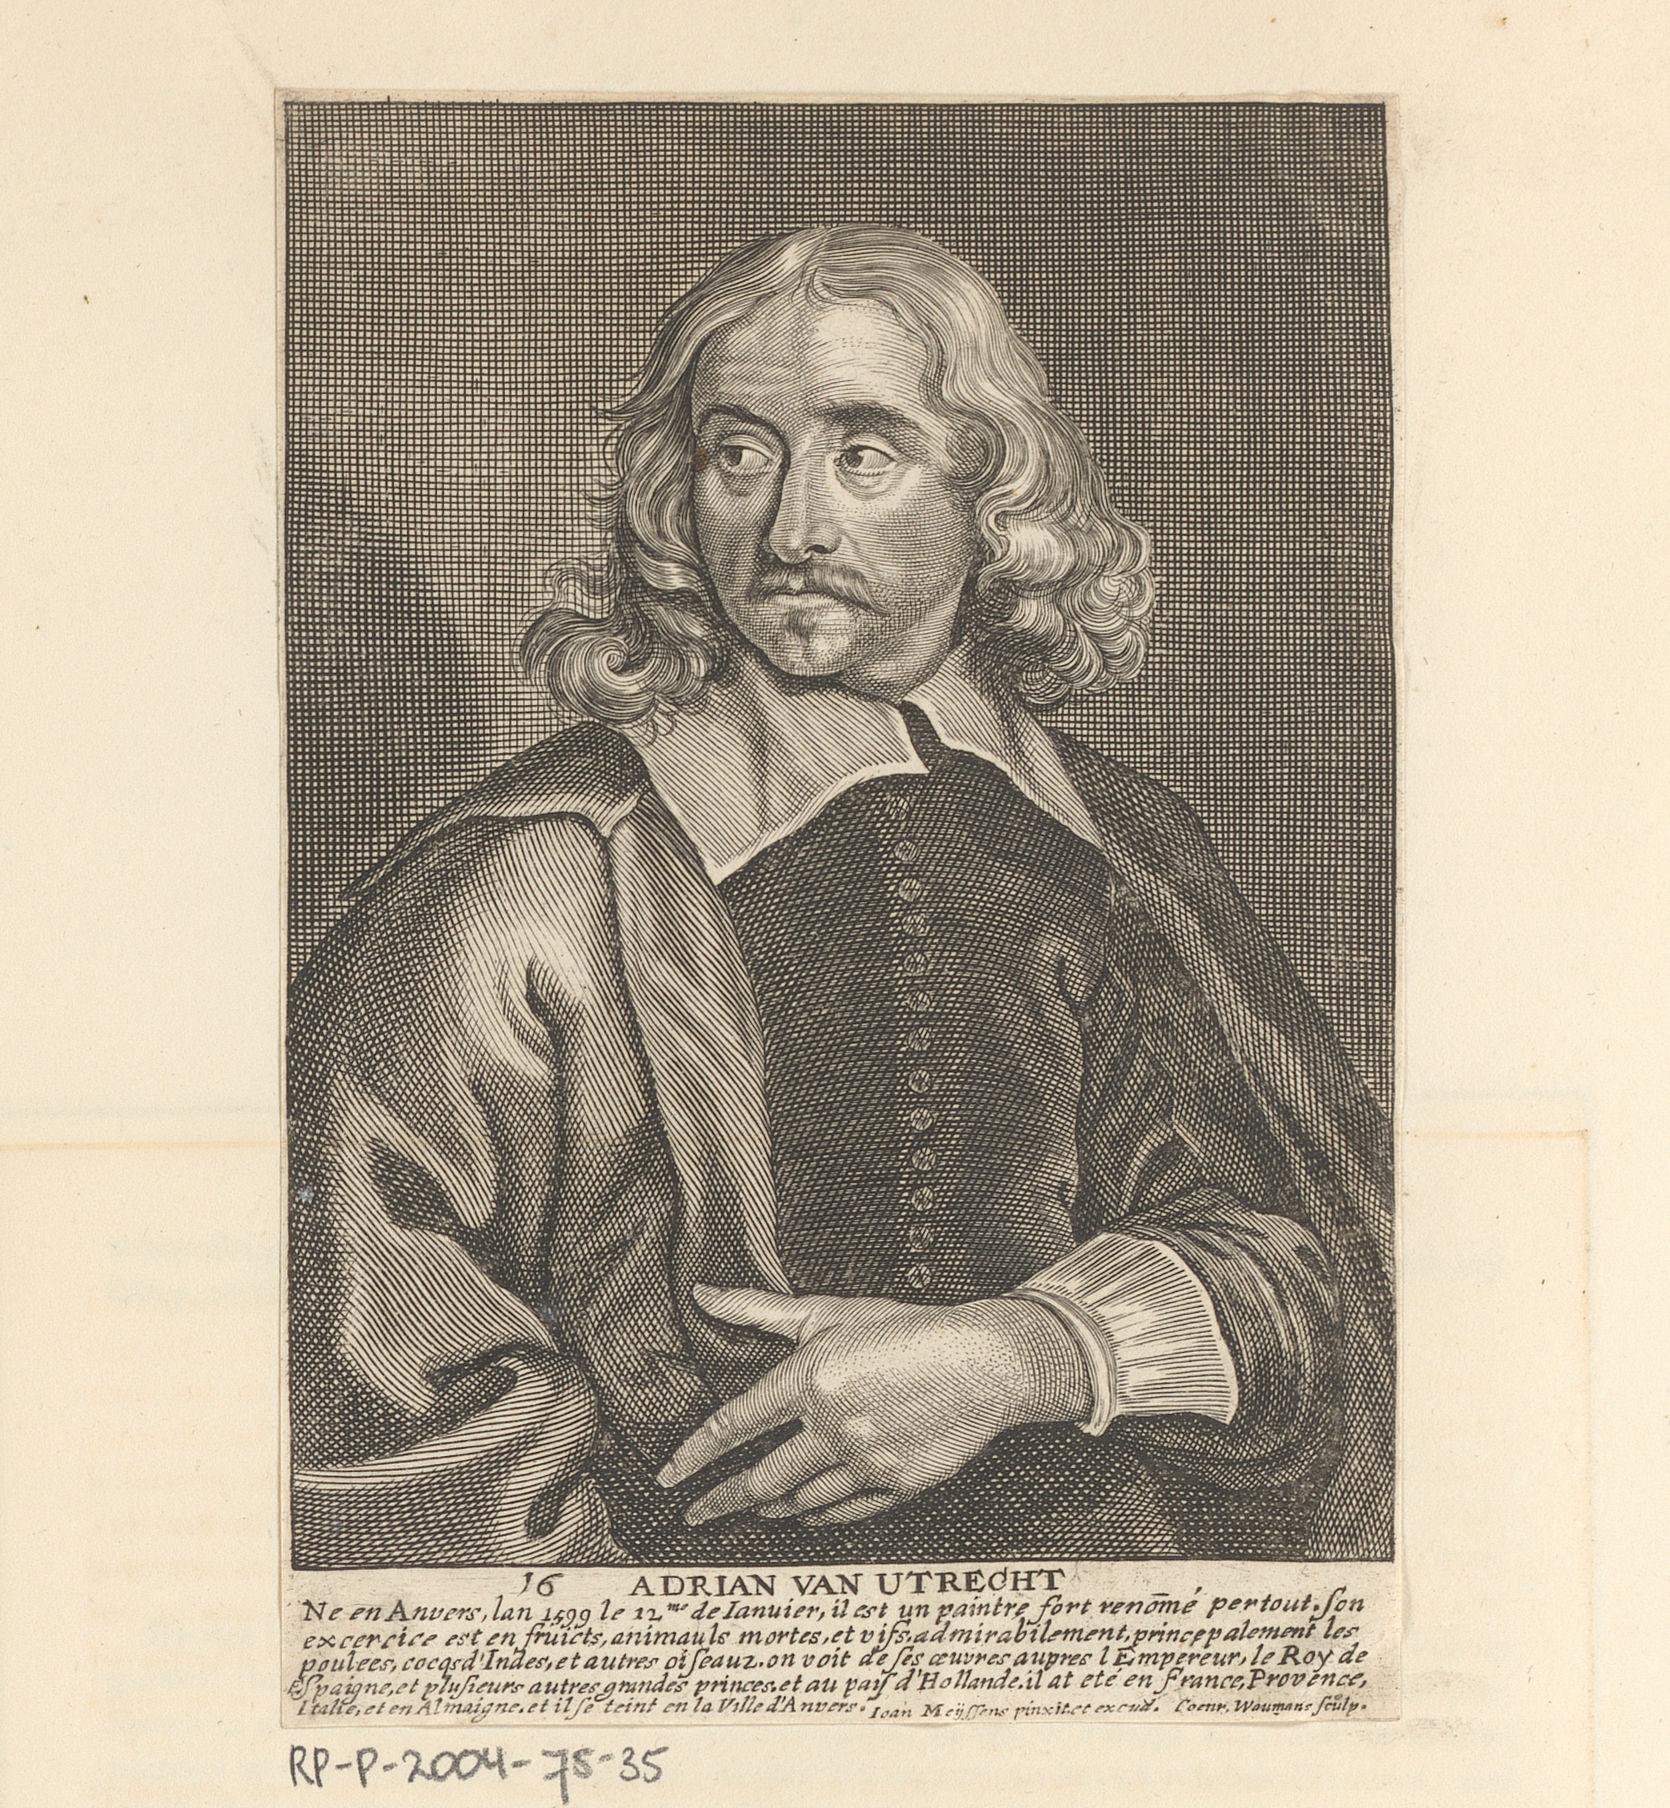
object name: book illustration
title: Portret van Adriaen van Utrecht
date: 1649-1662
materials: paper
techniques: engraving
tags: antwerp, painter, adriaen van utrecht, historical persons, portrait, self-portrait of painter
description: Huidige staat van prent (genummerd 16) gebruikt in: The Portraits of the Most Eminent Painters, and other Famous Artists (...). Londen: Olive Payne, 1739. Eerste bekende staat (ongenummerd) gebruikt in: Bie, Cornelis De. Het gulden Cabinet vande edel vry schilder const, inhoudende den lof vande vermarste schilders, architecte, beldthowers ende plaetsnyders van dese eeuw. Antwerpen: Joannes Meyssens, 1662 [1661 foutief op titelpagina]. En mogelijk ook al in: Meyssens, Joannes. Image de divers hommes desprit sublime qui par leur art et science deburovent vivre eternellement et des quels la louange et renommée faict estonner le monde. 2 dln. Antwerpen: Joannes Meyssens, 1649. Tweede bekende staat (genummerd 35) gebruikt in: Resta, Sebastiano. The true effigies of the most eminent painters and other famous artists that have flourished in Europe. Londen, 1694. De samensteller heeft deze prent in het album geplakt als illustratie bij: Pilkington, Matthew en Johann Heinrich Füssli. A dictionary of painters, from the revival of the art to the present period. 4 dln. Londen: John Crowder, 1805, dl. 4, p. 598.